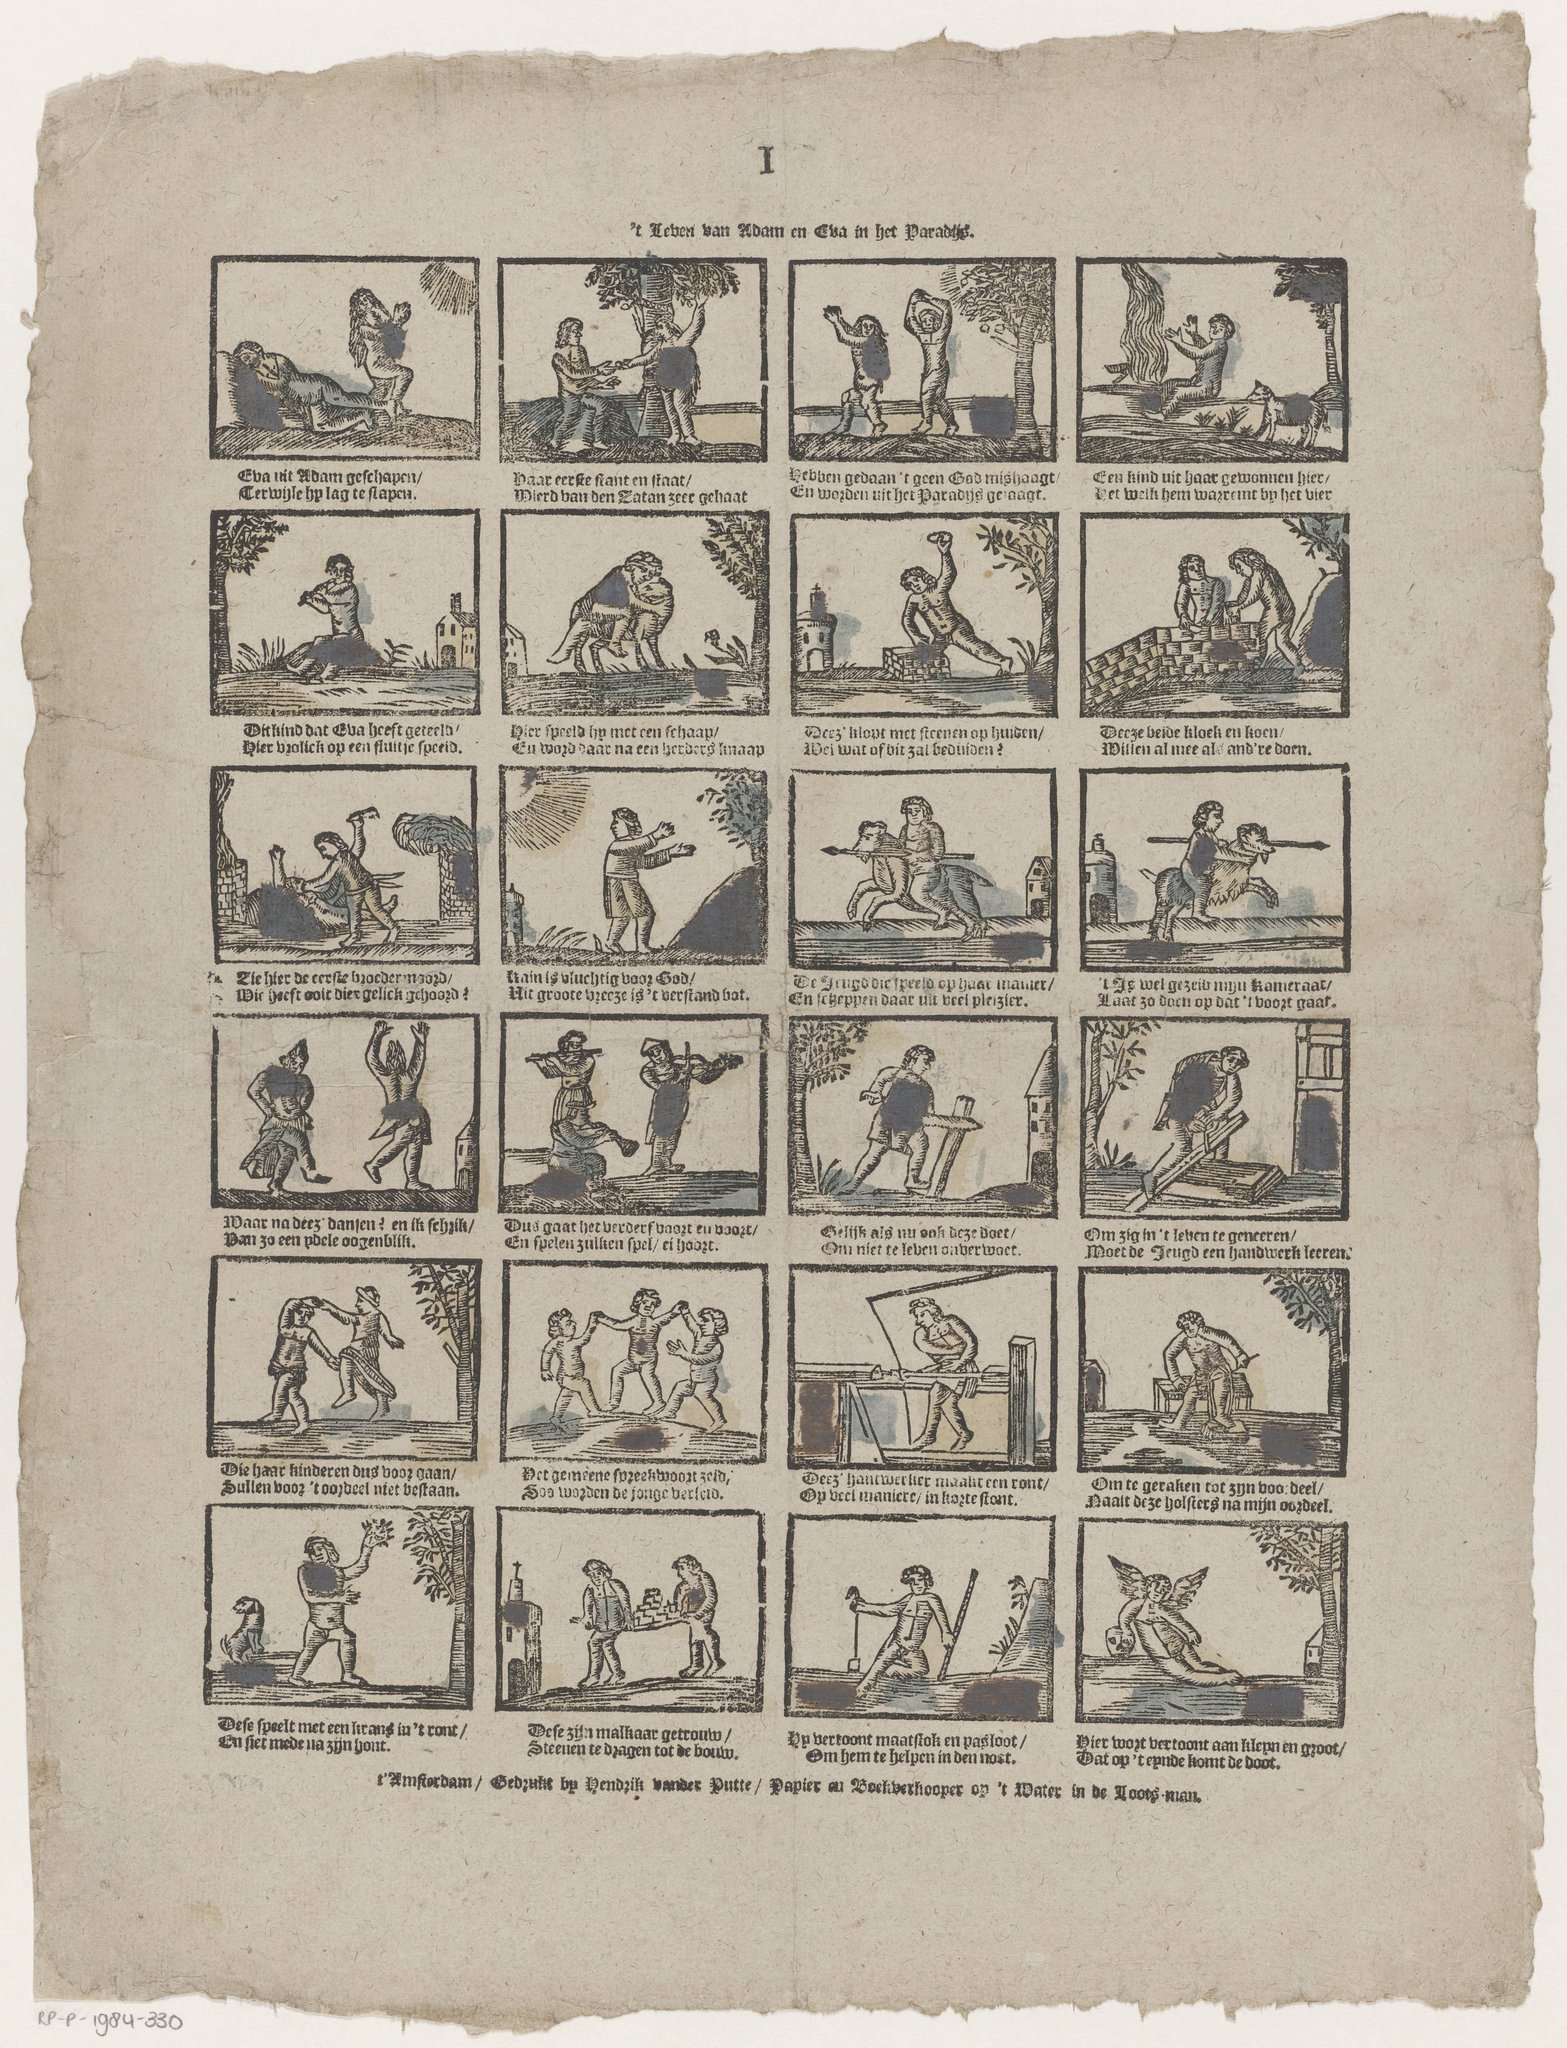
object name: popular print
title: 't Leven van Adam en Eva in het paradijs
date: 1761-1765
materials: paper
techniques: colour, letterpress printing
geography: netherlands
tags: craft-production, skilled handiwork, children's games and plays, old testament, crafts and industries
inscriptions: collector's mark: Lugt 2760, collector's mark: Lugt 2228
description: Blad met 24 voorstellingen van verhalen uit het Nieuwe Testament en van kinderspelen en ambachtslieden. Onder elke afbeelding een tweeregelig vers. Genummerd midden boven: 1.